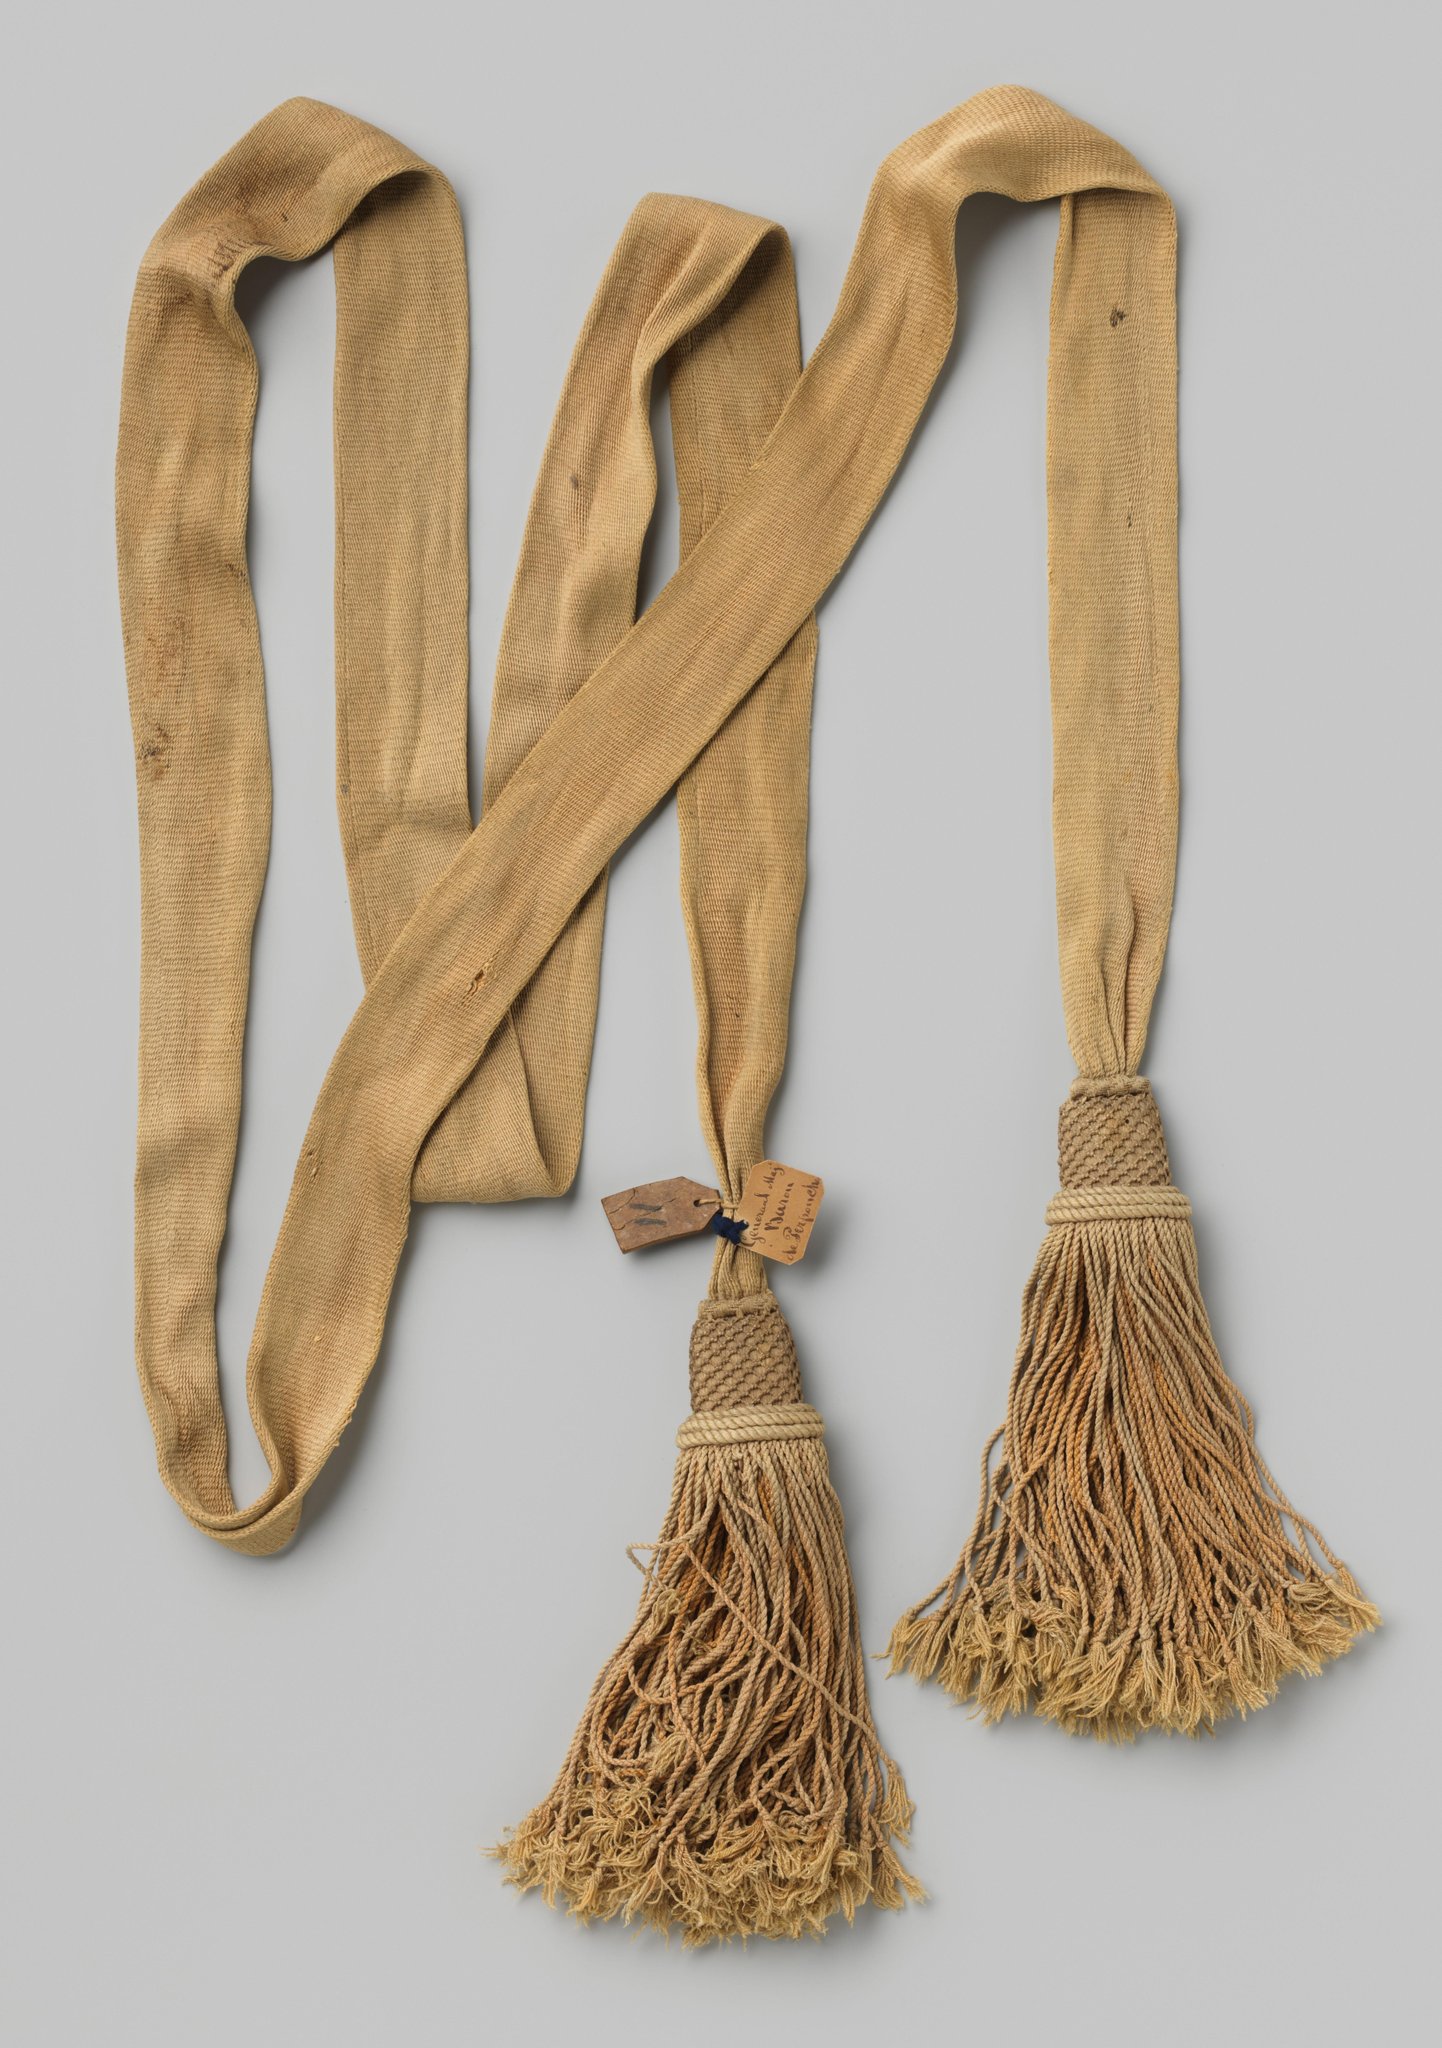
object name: sash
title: Sjerp voor opperofficieren, ca. 1830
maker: Anonymous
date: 1830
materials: wood, wool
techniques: braiding, knotting, stitching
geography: netherlands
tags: netherlands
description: Sjerp van verfletst oranje koordzijde (band van Egypt. vlechtwerk) met kwasten (zonder sterren) met enkele beschadigingen. De sjerp is omgevouwen en vastgestikt. Aan een der zijdes hangt, aan een touw een zeshoekig leren label met nr. 11. Hierbij is aan een blauw lint een achthoekig kaart bevestigd met de tekst Generaal maj. baron de Perponcher. Beide uiteinden van de sjerp eindigen in een platte kwast, bestaande uit een houten kern, waaromheen oranje draad is gewikkeld. Hierover is gevlochten en geknoopt koord aangebracht. Aan de onderzijdes van de kwasten zijn drie rijen van dito koordzijde aangebracht. Hieraan hangen dunne dito franjes. Elke franje is aan de onderzijde voorzien van een knoop. Binnenzijde van de kwasten bestaat uit een ovaal stuk hout, dat is uitgehold, en omwikkeld is met oranje zijden draad. In de uitholling zijn ook franjes gemonteerd.